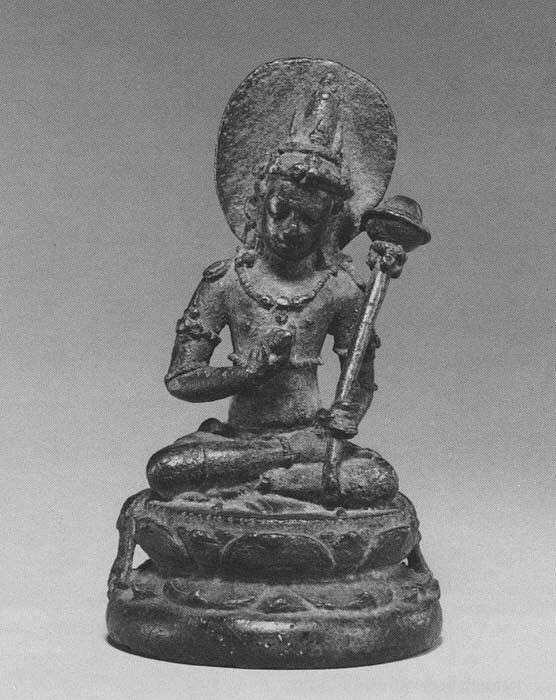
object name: figure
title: Seated Deity from an Esoteric Buddhist Mandala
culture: indonesian, javanese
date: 951-975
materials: bronze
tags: buddhism,deities